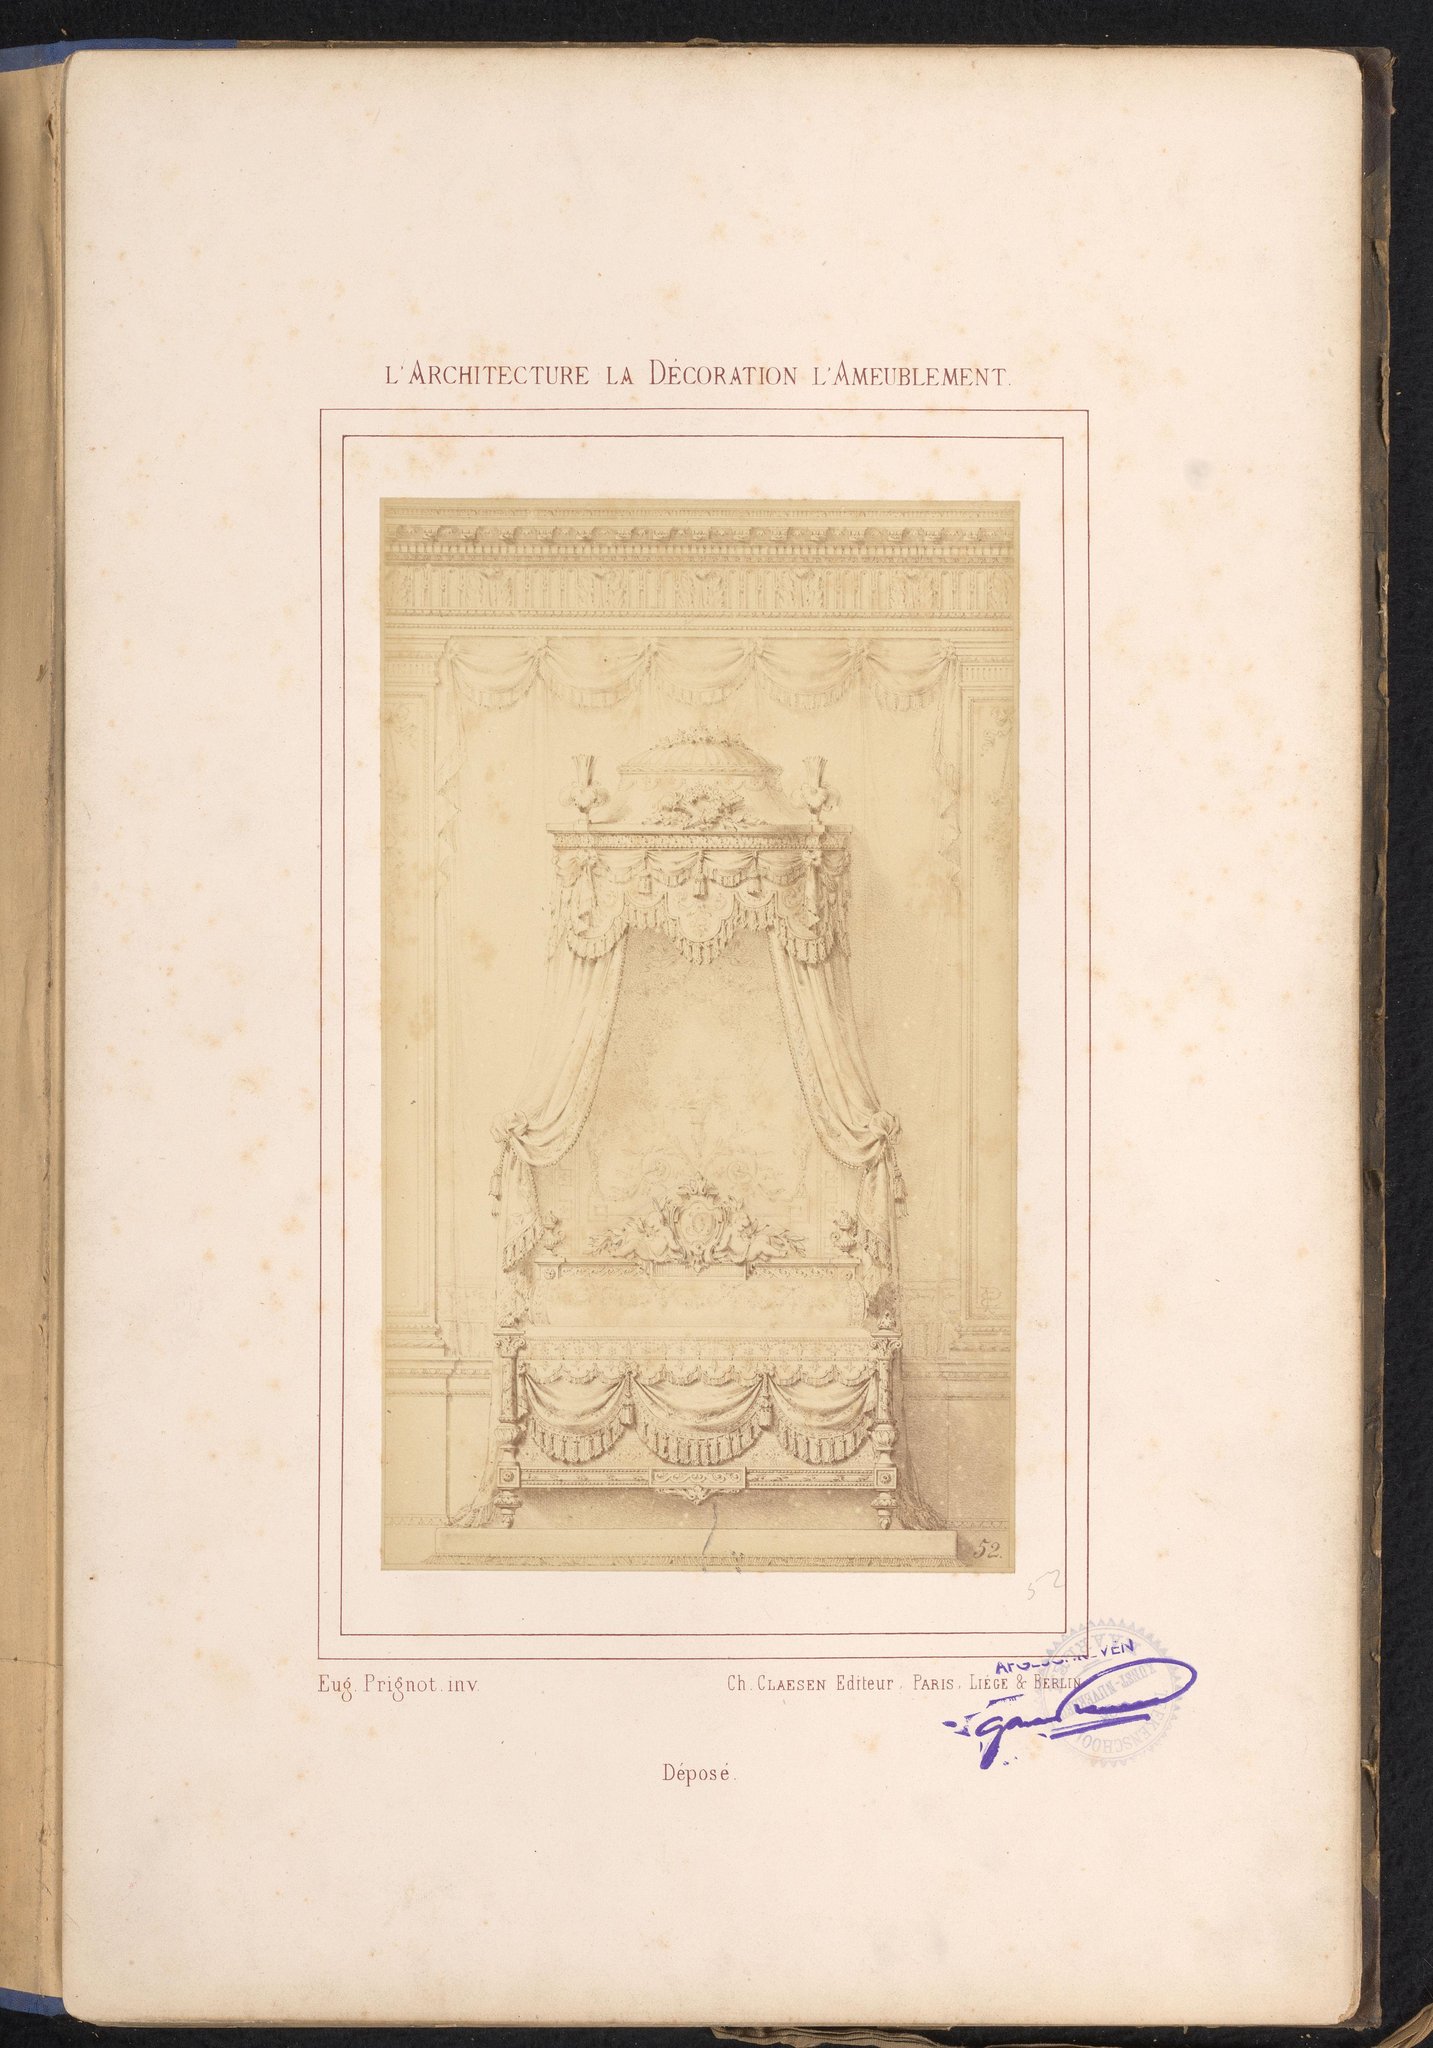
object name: photograph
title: L'Architecture la Décoration l'Ameublement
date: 1873-1880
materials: cardboard, paper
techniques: albumen print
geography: liège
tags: bed, wall-covering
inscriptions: number: ‘52’, stamp: ‘TEEKENSCHOOL/ VOOR/ KUNST-NIJVERHEID/ HAARLEM’, stamp: ‘AFGESCHREVEN/ [...]’, inscription: ‘Déposé’, inscription: ‘Eug. Prignot. inv.’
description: Deze foto maakt deel uit van een omslag met 61 foto's op 61 bladen.